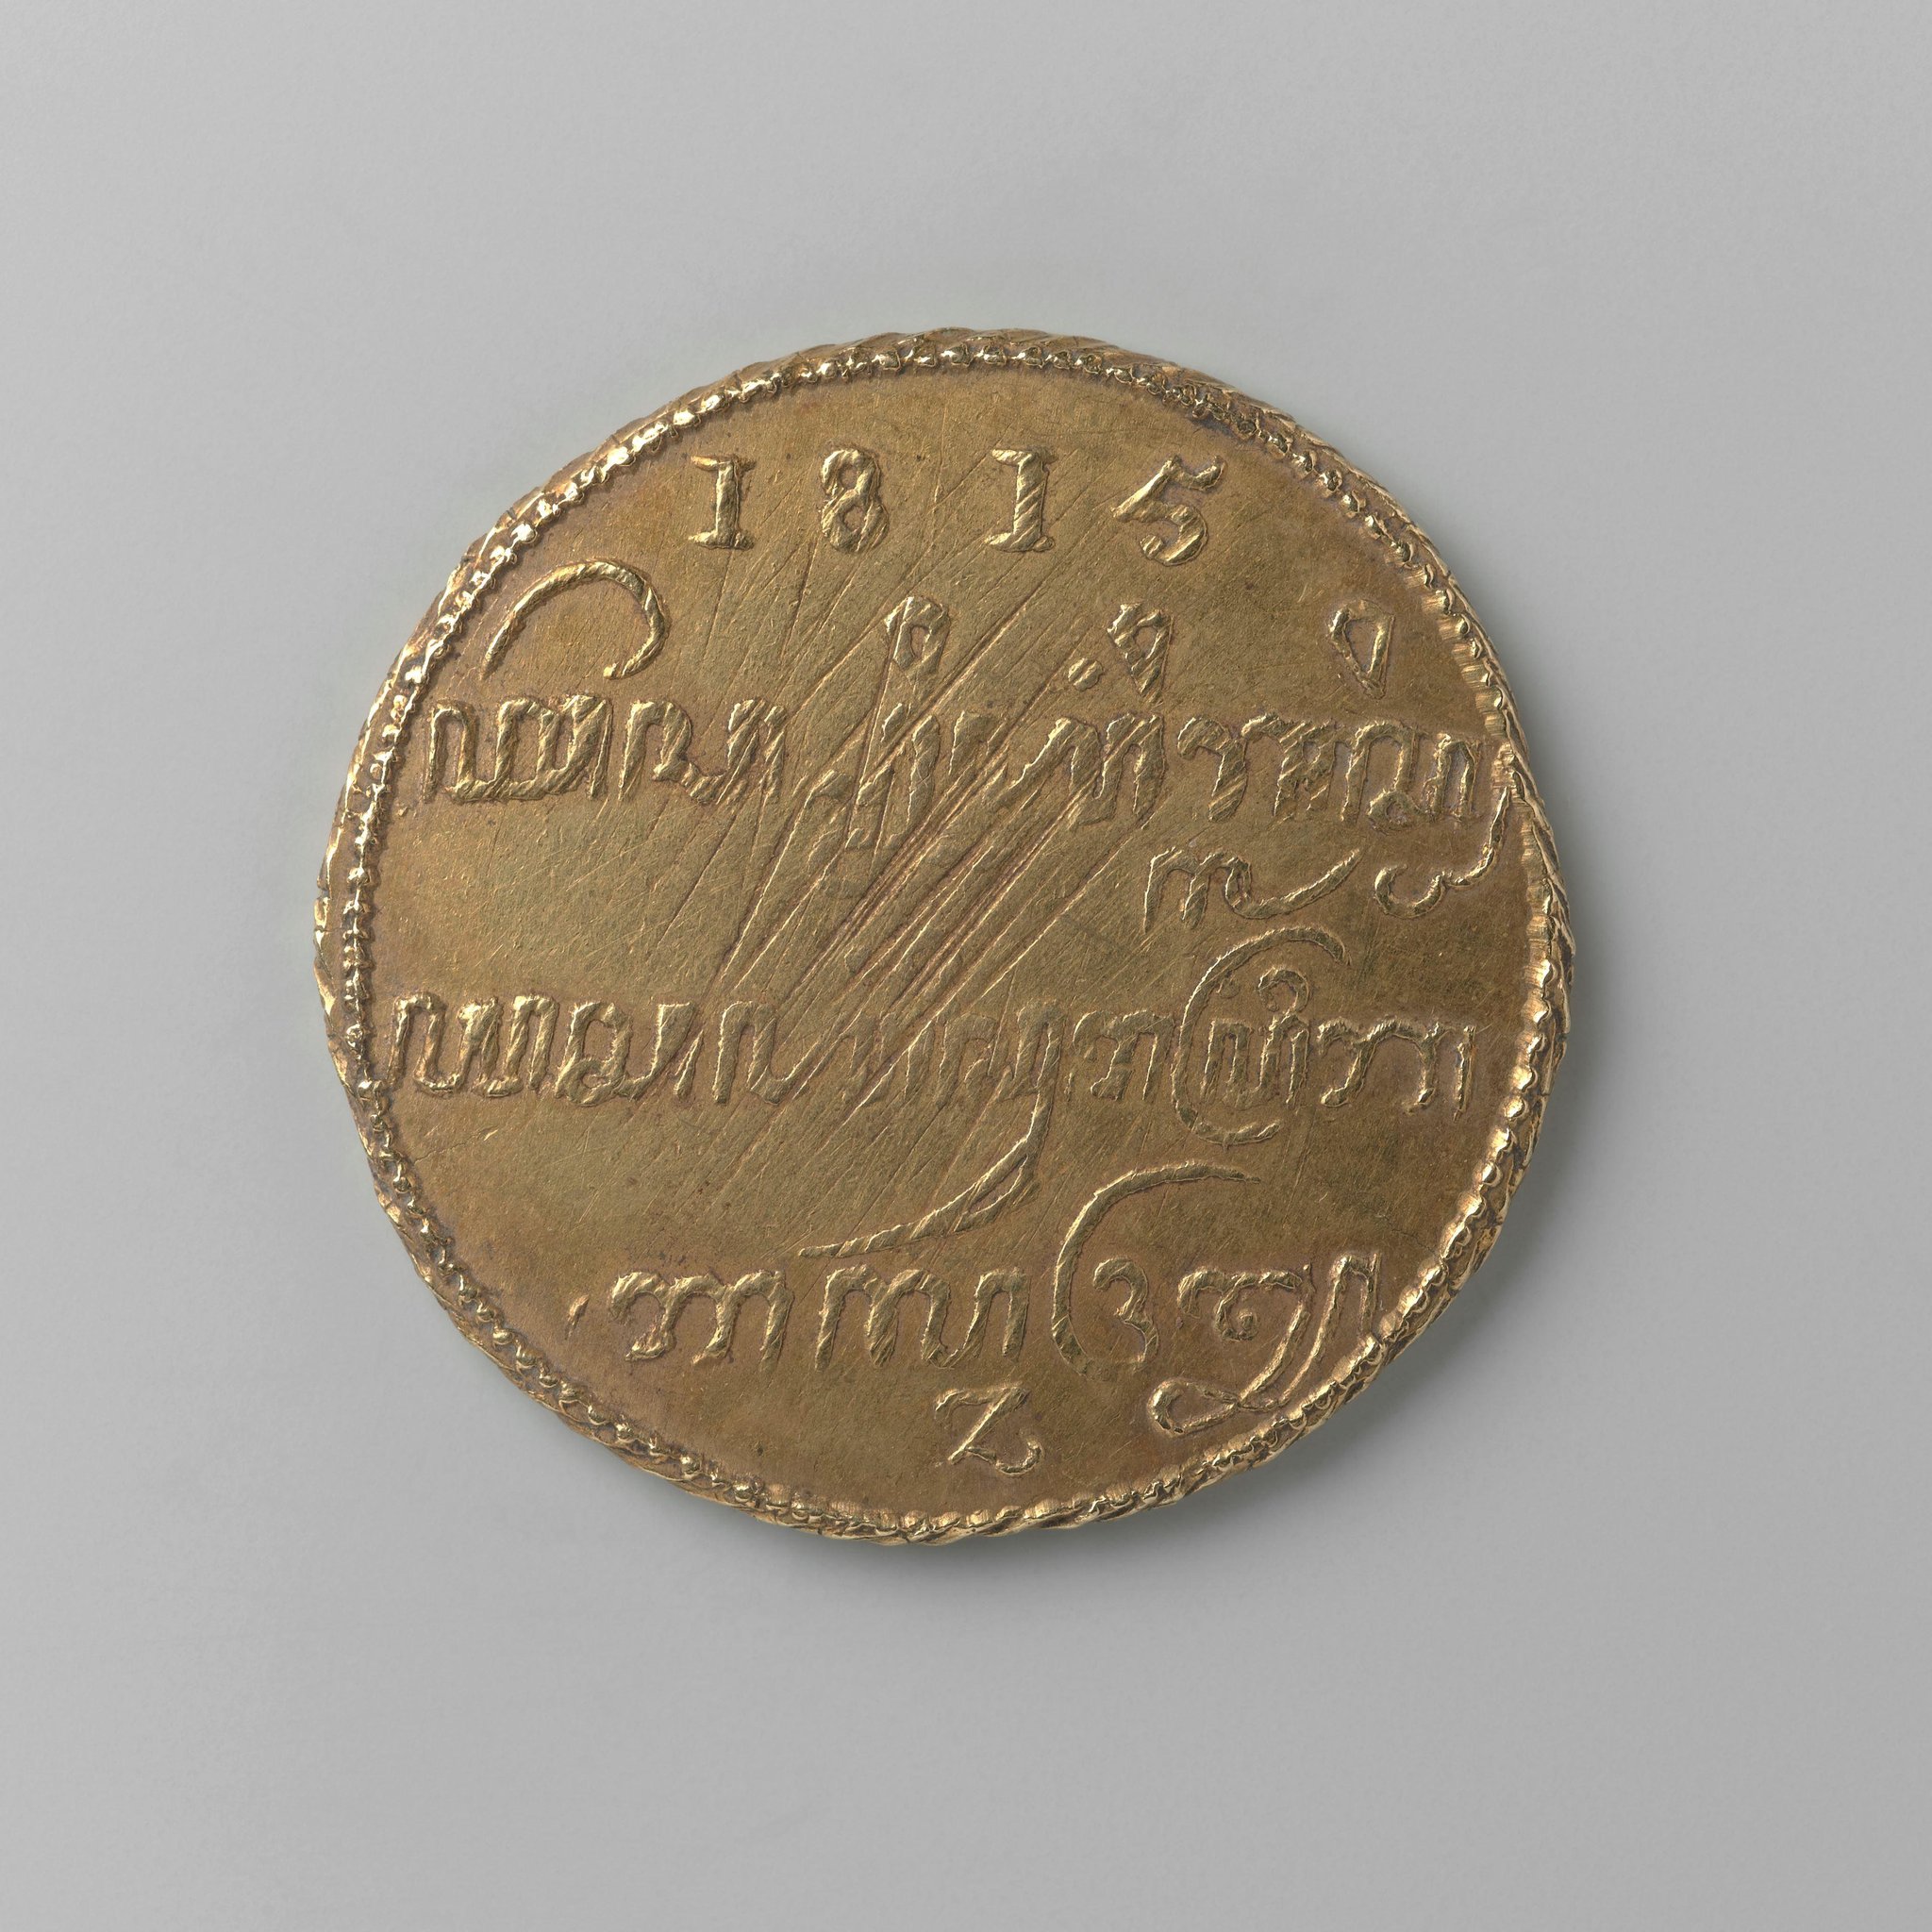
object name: halve gouden ropij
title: ½ gouden ropij voor Nederlands Indië tijdens Brits bestuur, 1815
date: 1815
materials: gold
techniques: striking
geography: surabaya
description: Gouden munt. Voorzijde: drieregelig opschrift in het Javaans met op onderste regel jaartal. Daarboven jaartal in Christelijke jaartelling in Arabische cijfers en daaronder muntmeesterteken Z [=muntmeester Zwekkert]. Keerzijde: vijfregelig opschrift in het Arabisch, waariin jaartal in Islamitische jaartelling. Kabelrand. Op voor- en keerzijde toets-strepen.